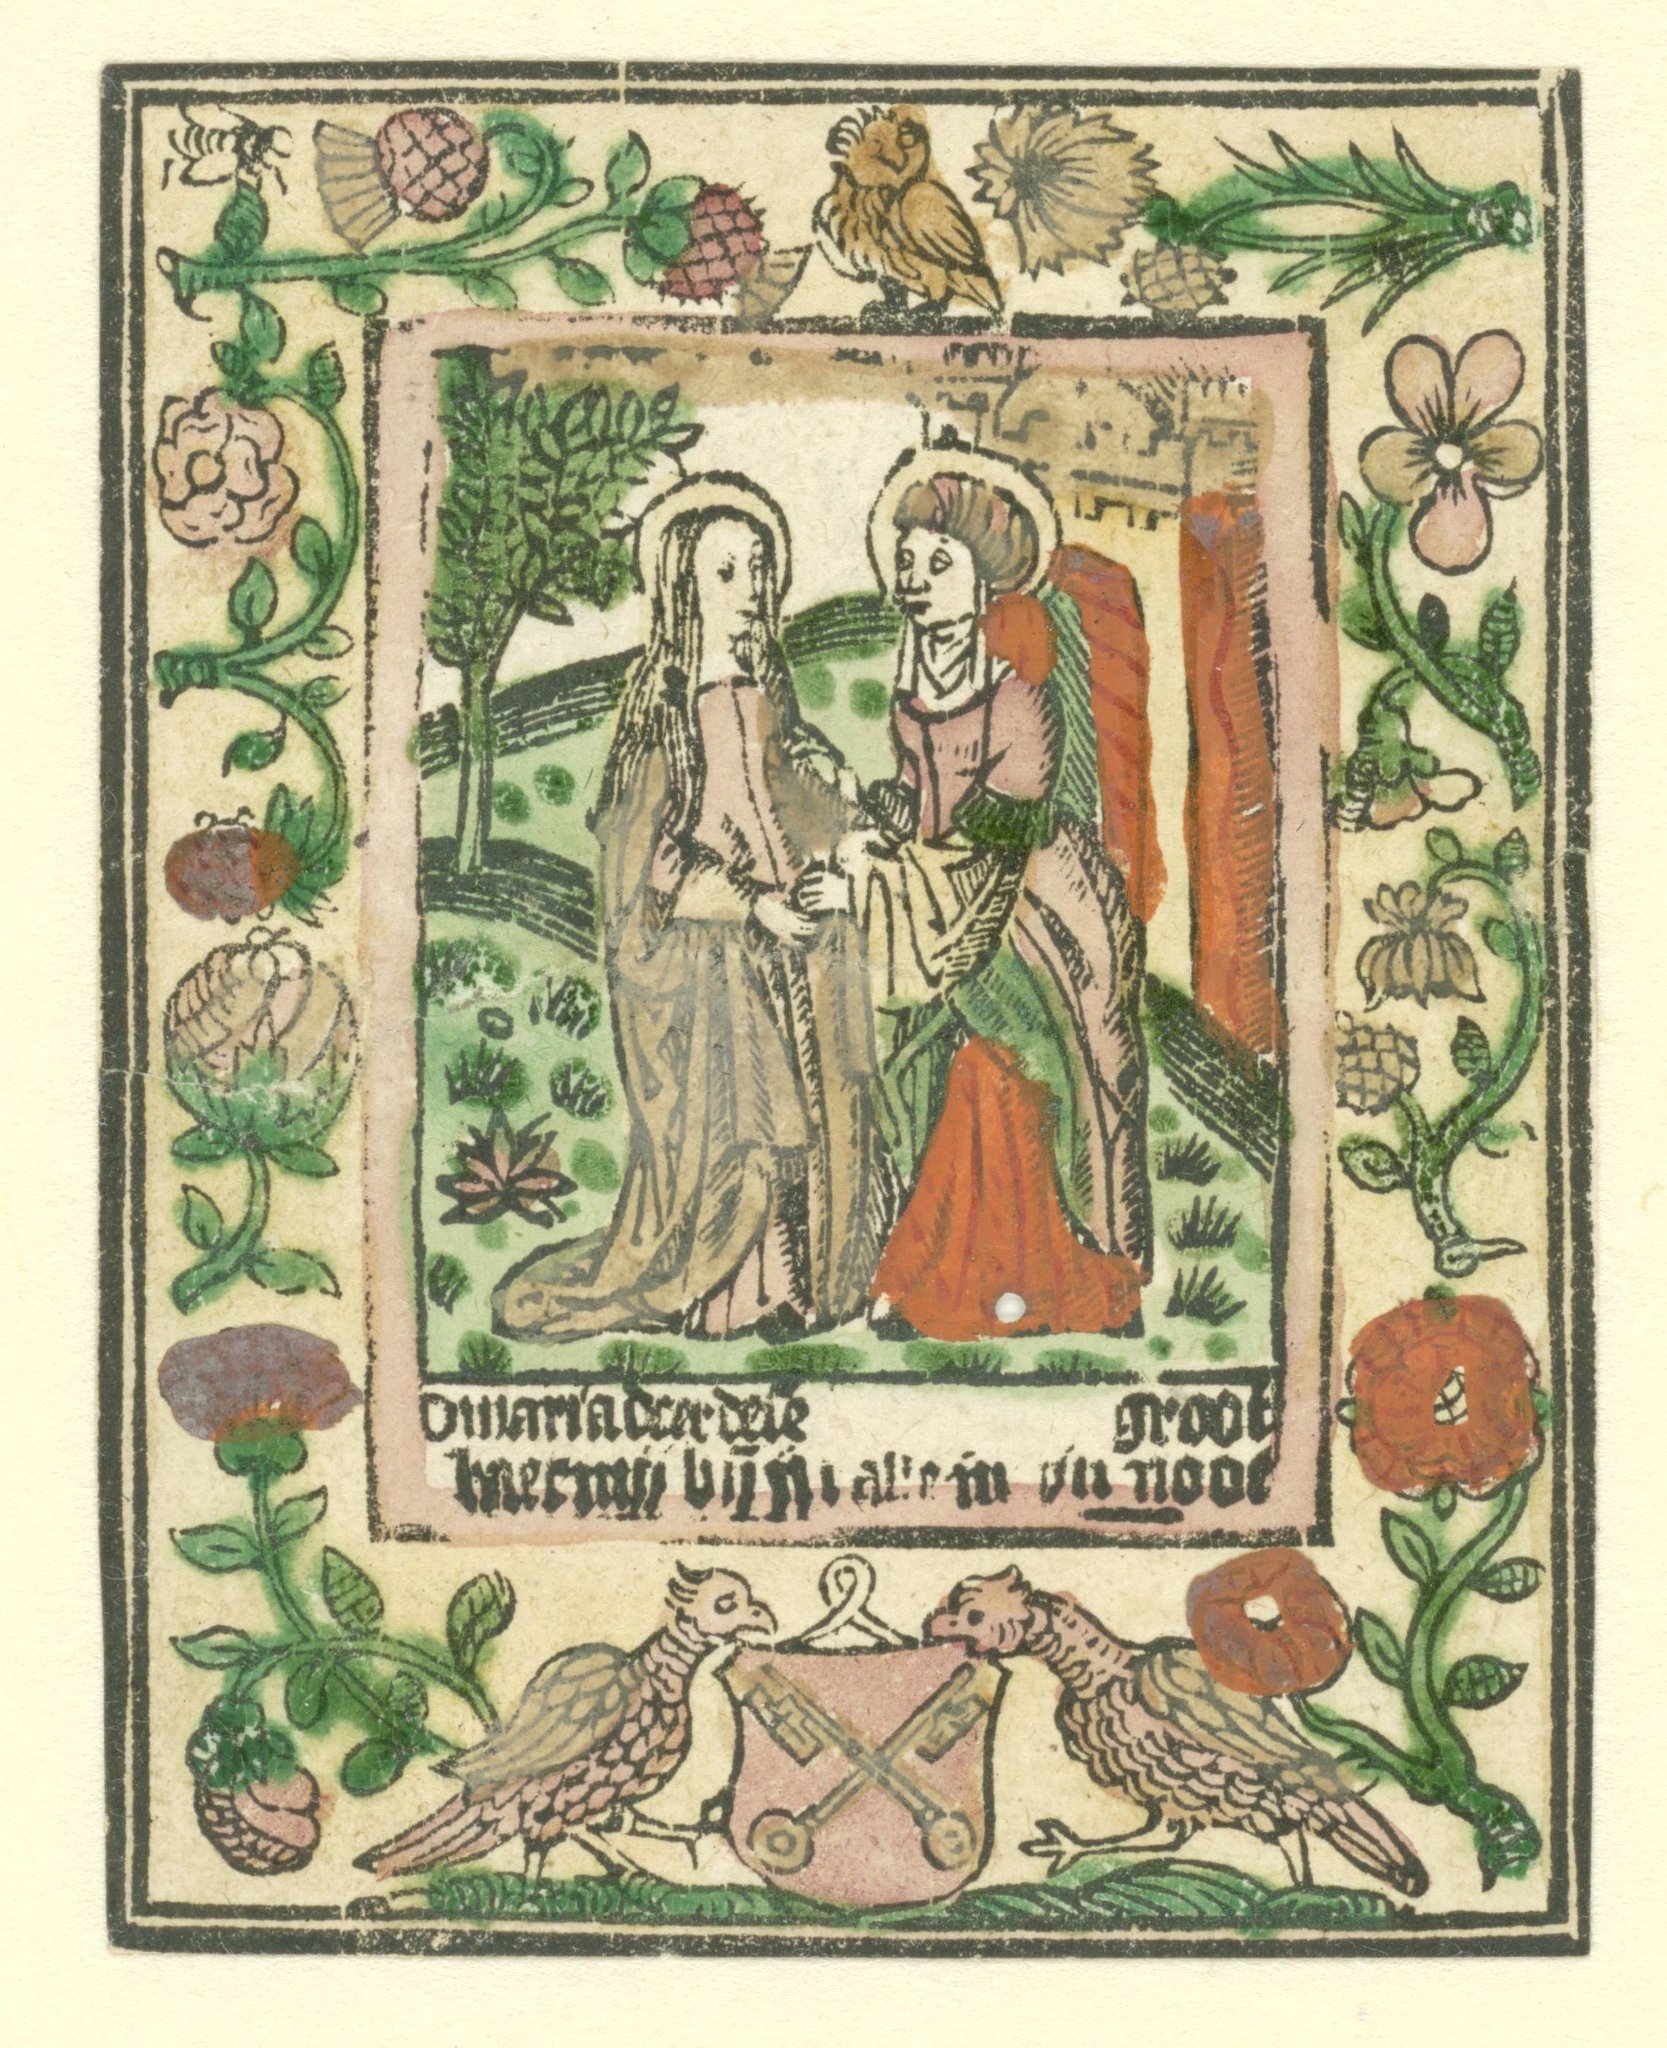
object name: print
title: Visitatie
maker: Anonymous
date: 1490-1510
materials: paper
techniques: hand coloring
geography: leiden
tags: mary's arrival in judah, flowers ~ ornament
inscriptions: collector's mark: Lugt 2228a, inscription: ‘3’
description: Het bezoek van Maria aan Elisabeth. In een rand bestaande uit bloemornament vogels en het wapen van Leiden. Onder de voorstelling: O Maria doer dese...